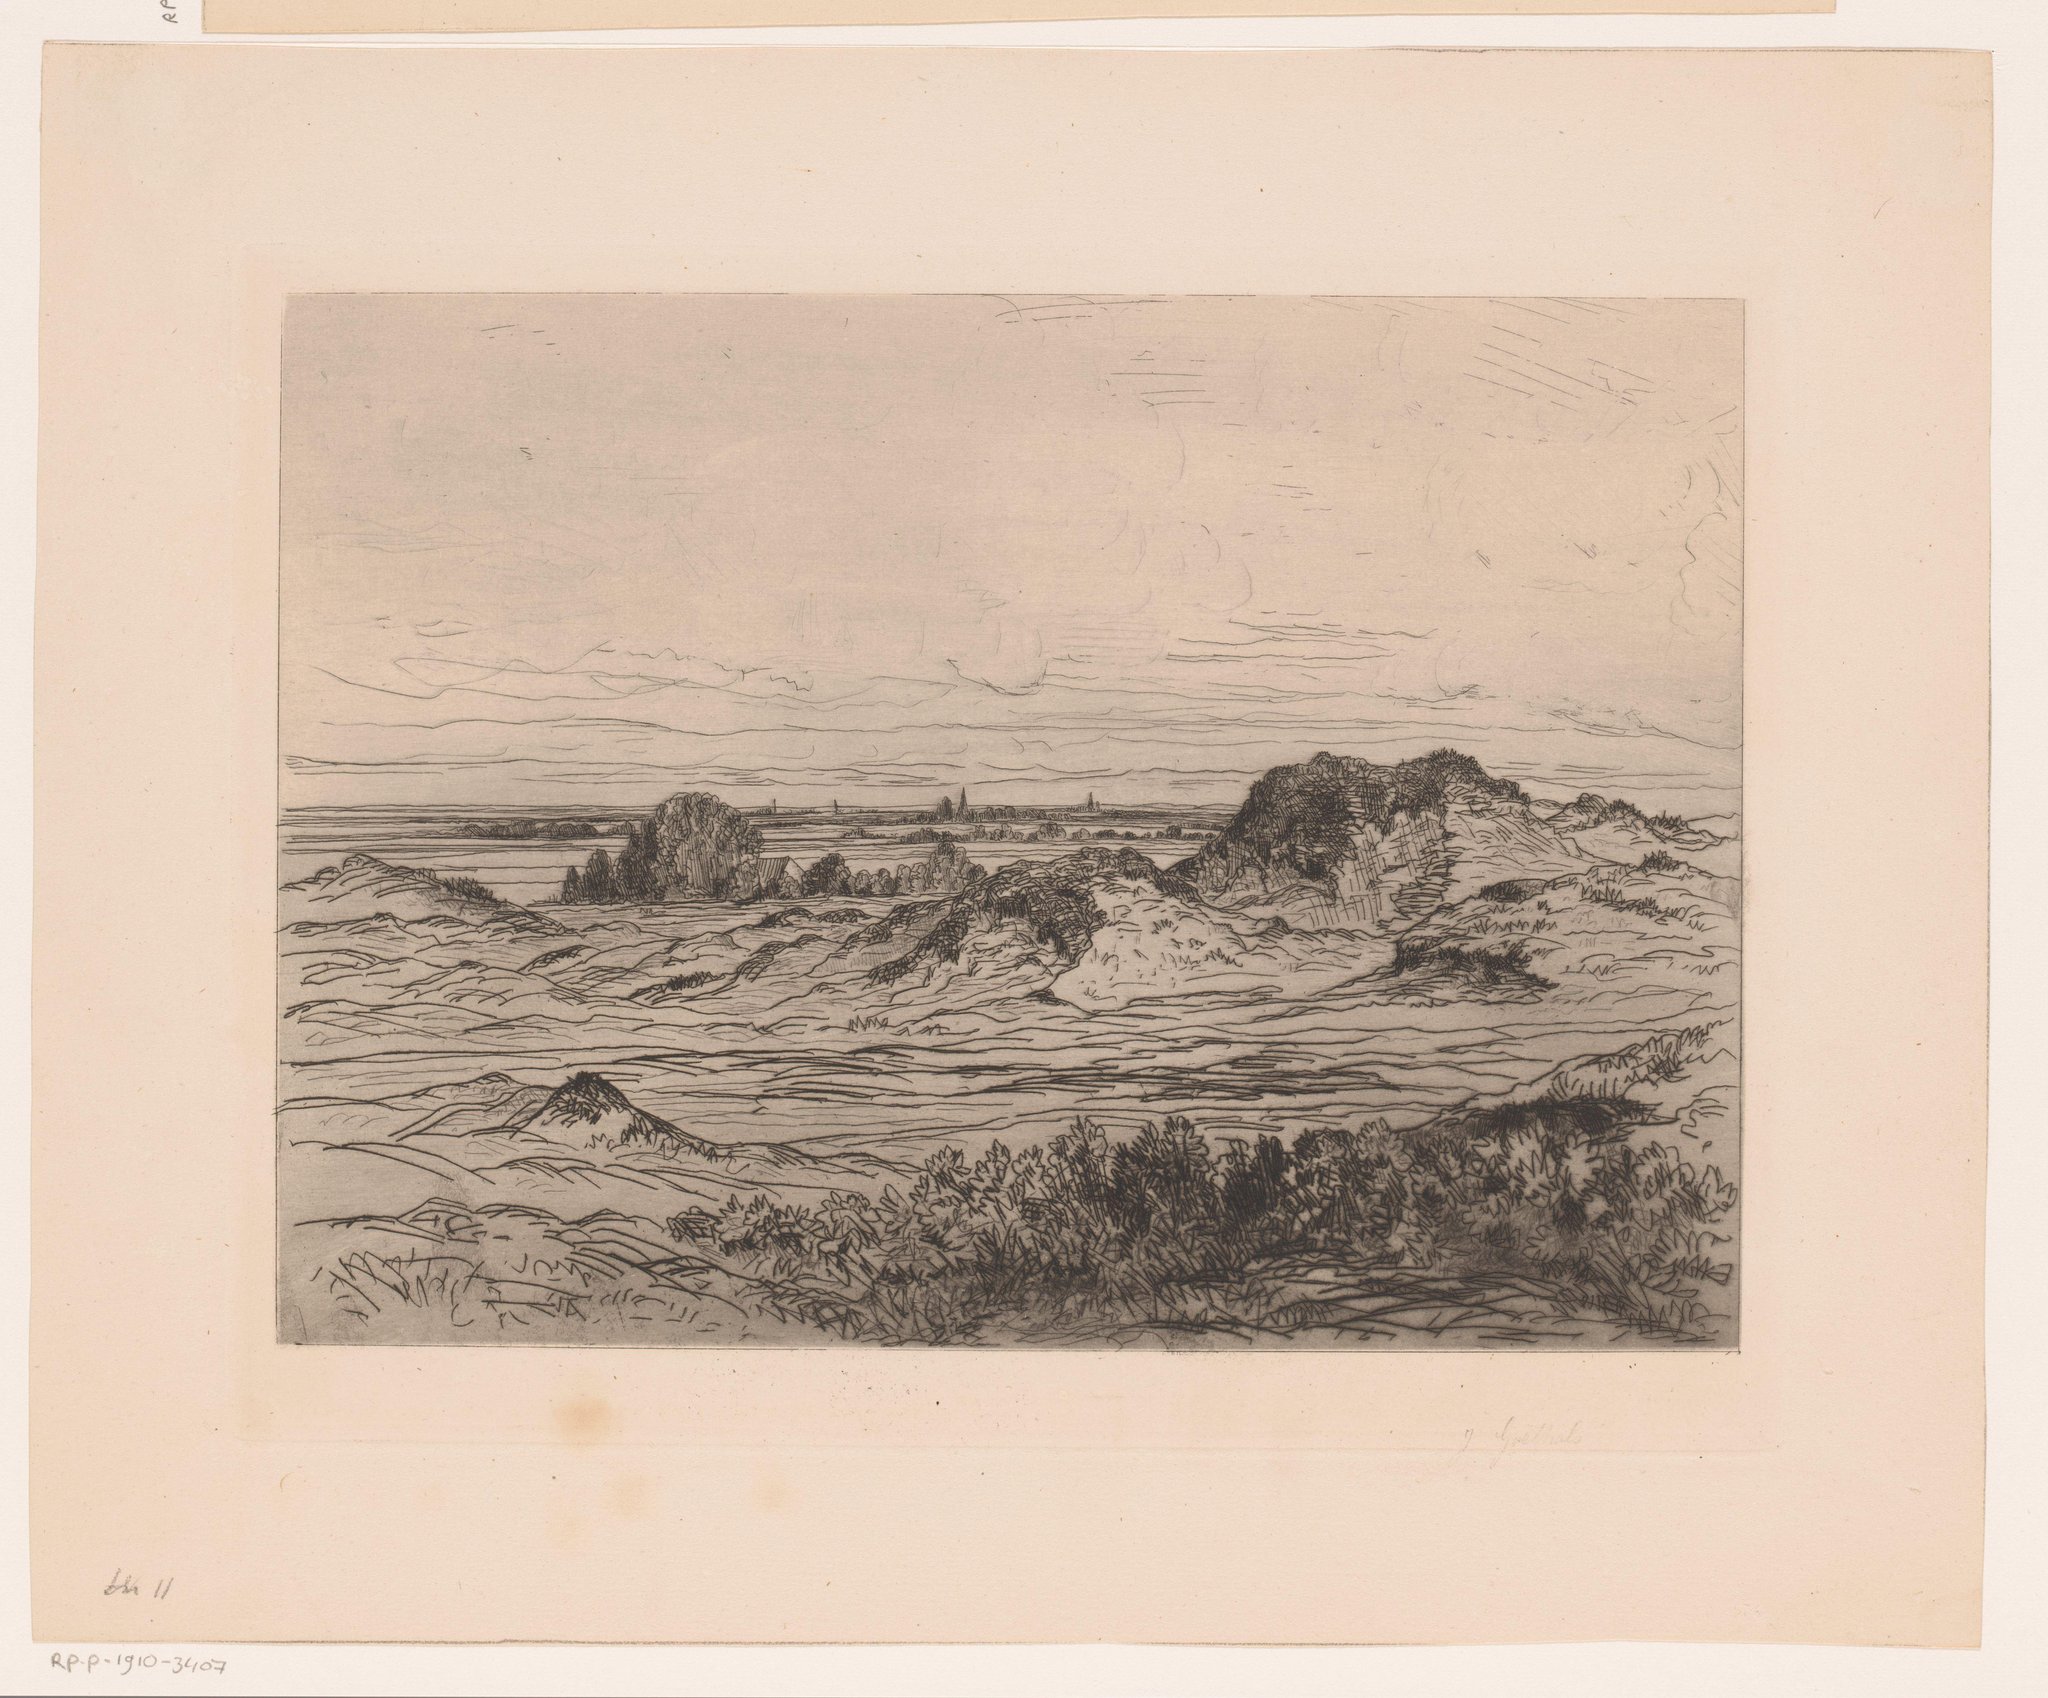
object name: print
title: Duinen bij Nieuwpoort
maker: jules marie armand goethals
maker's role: print maker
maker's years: 1844-1902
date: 1854-1879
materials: paper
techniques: drypoint, etching, intaglio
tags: dunes (sea not visible); in the dunes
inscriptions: collector's mark: Lugt 2228